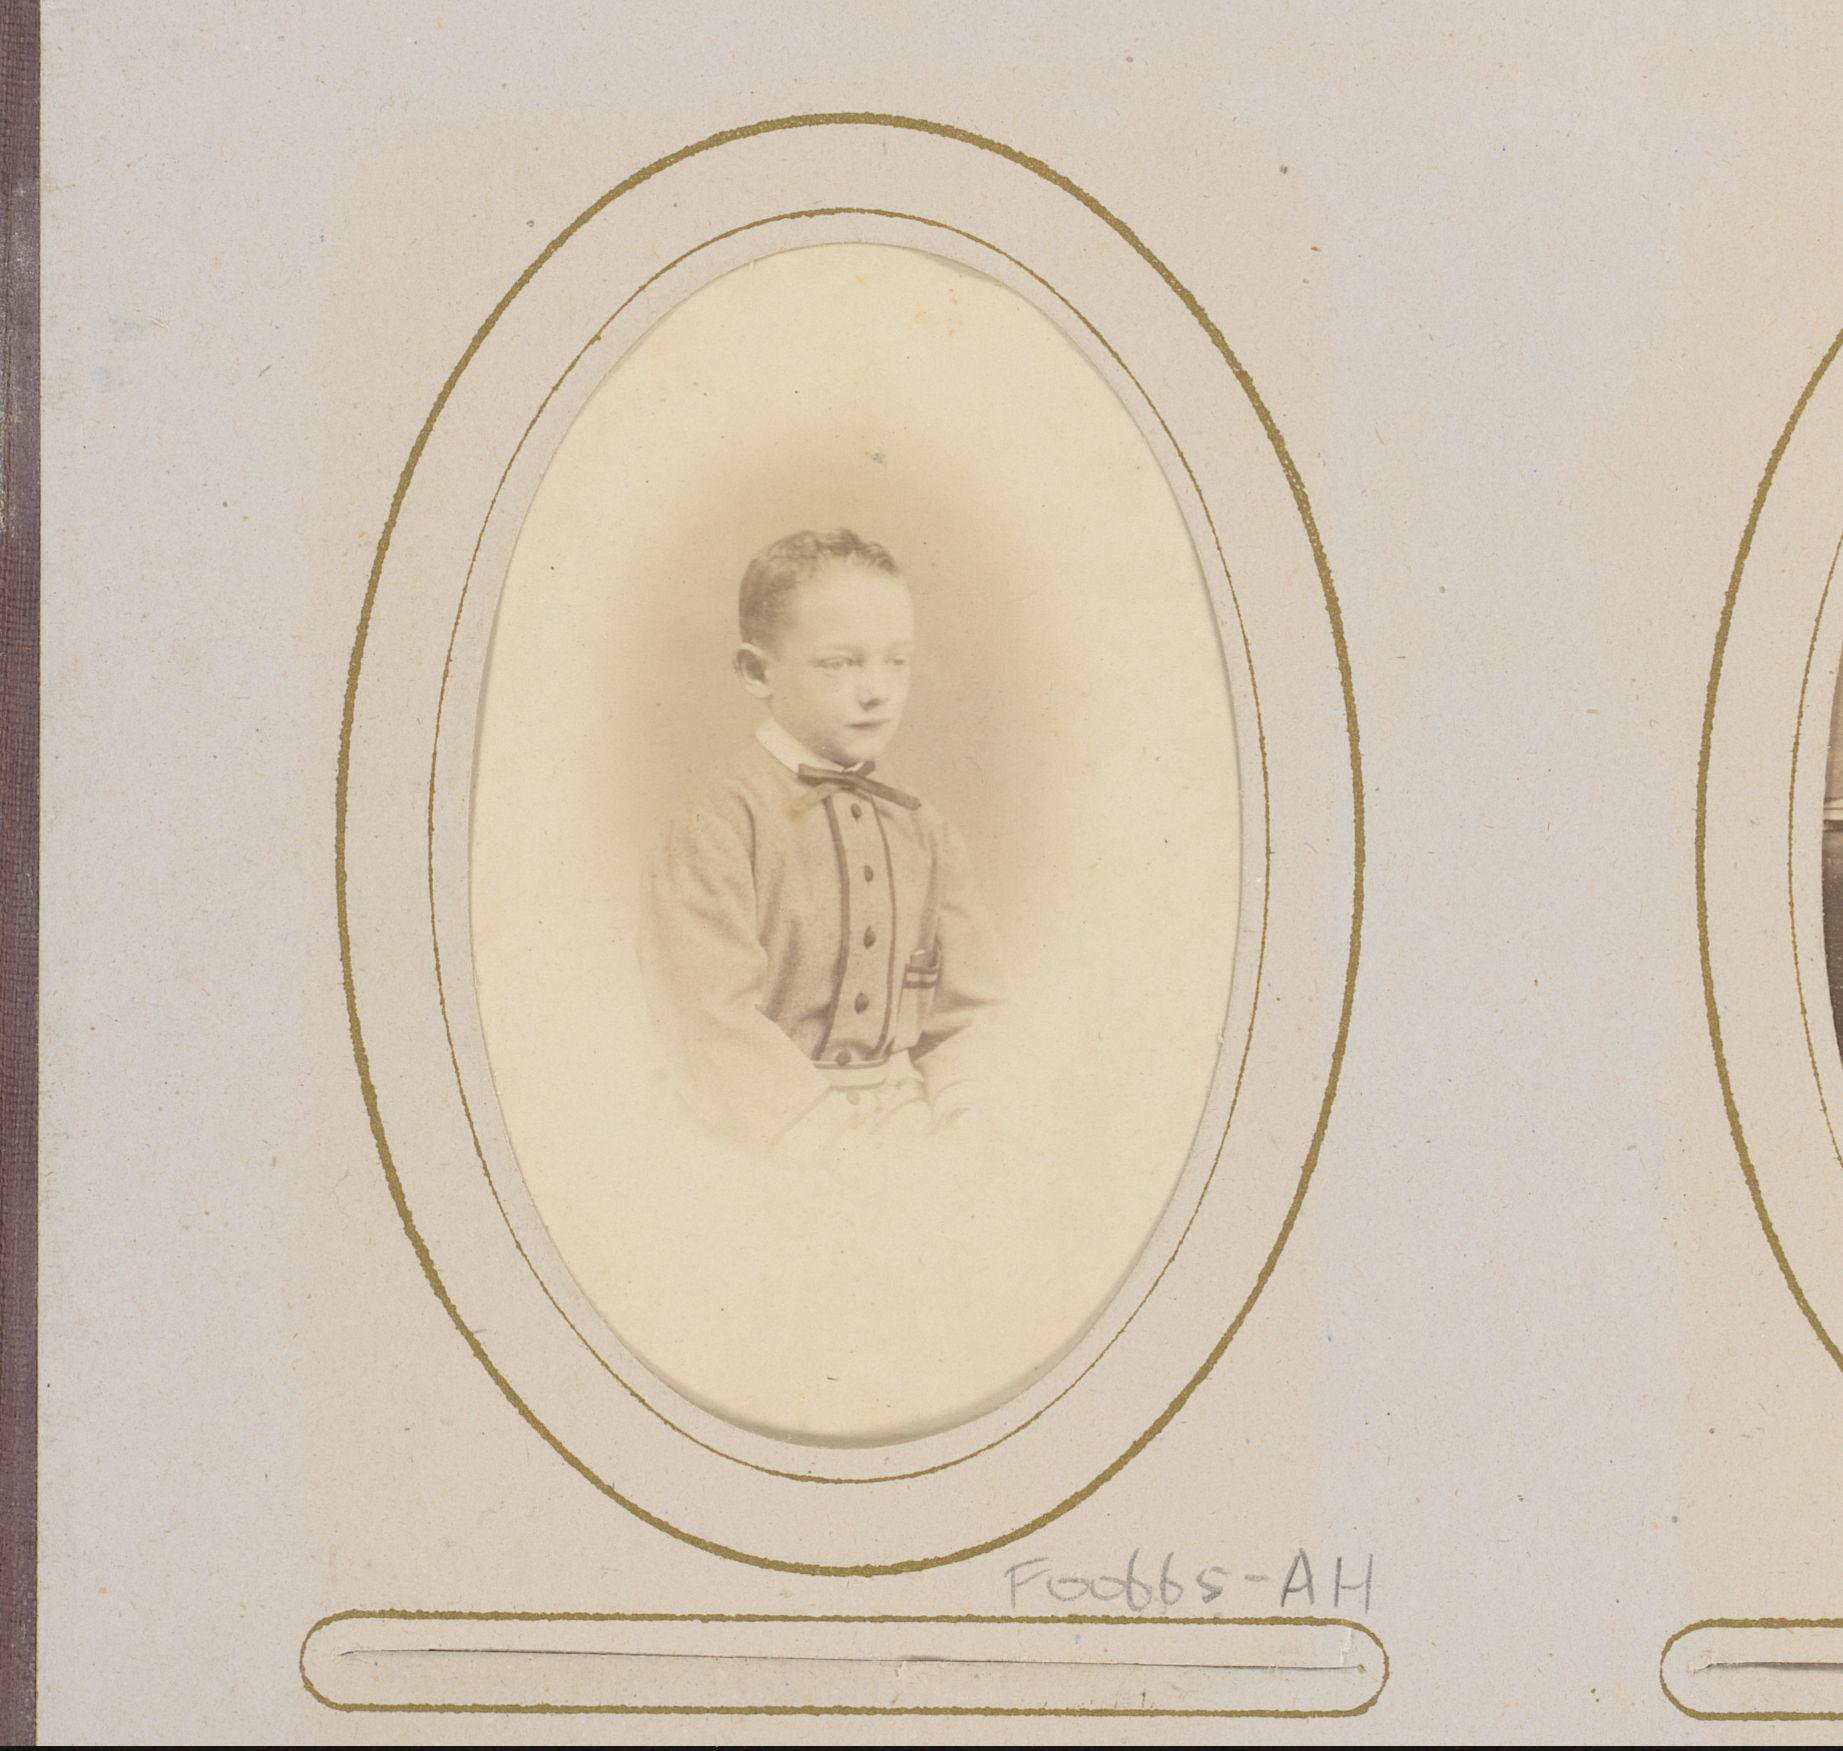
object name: photograph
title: Portret van een jongen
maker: hermanus siderius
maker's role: draughtsman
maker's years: 1819-1892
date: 1860-1892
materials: cardboard, photographic support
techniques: albumen print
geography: harlingen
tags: boy (child between toddler and youth)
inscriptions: inscription: ‘H. Siderius/ Harlingen’